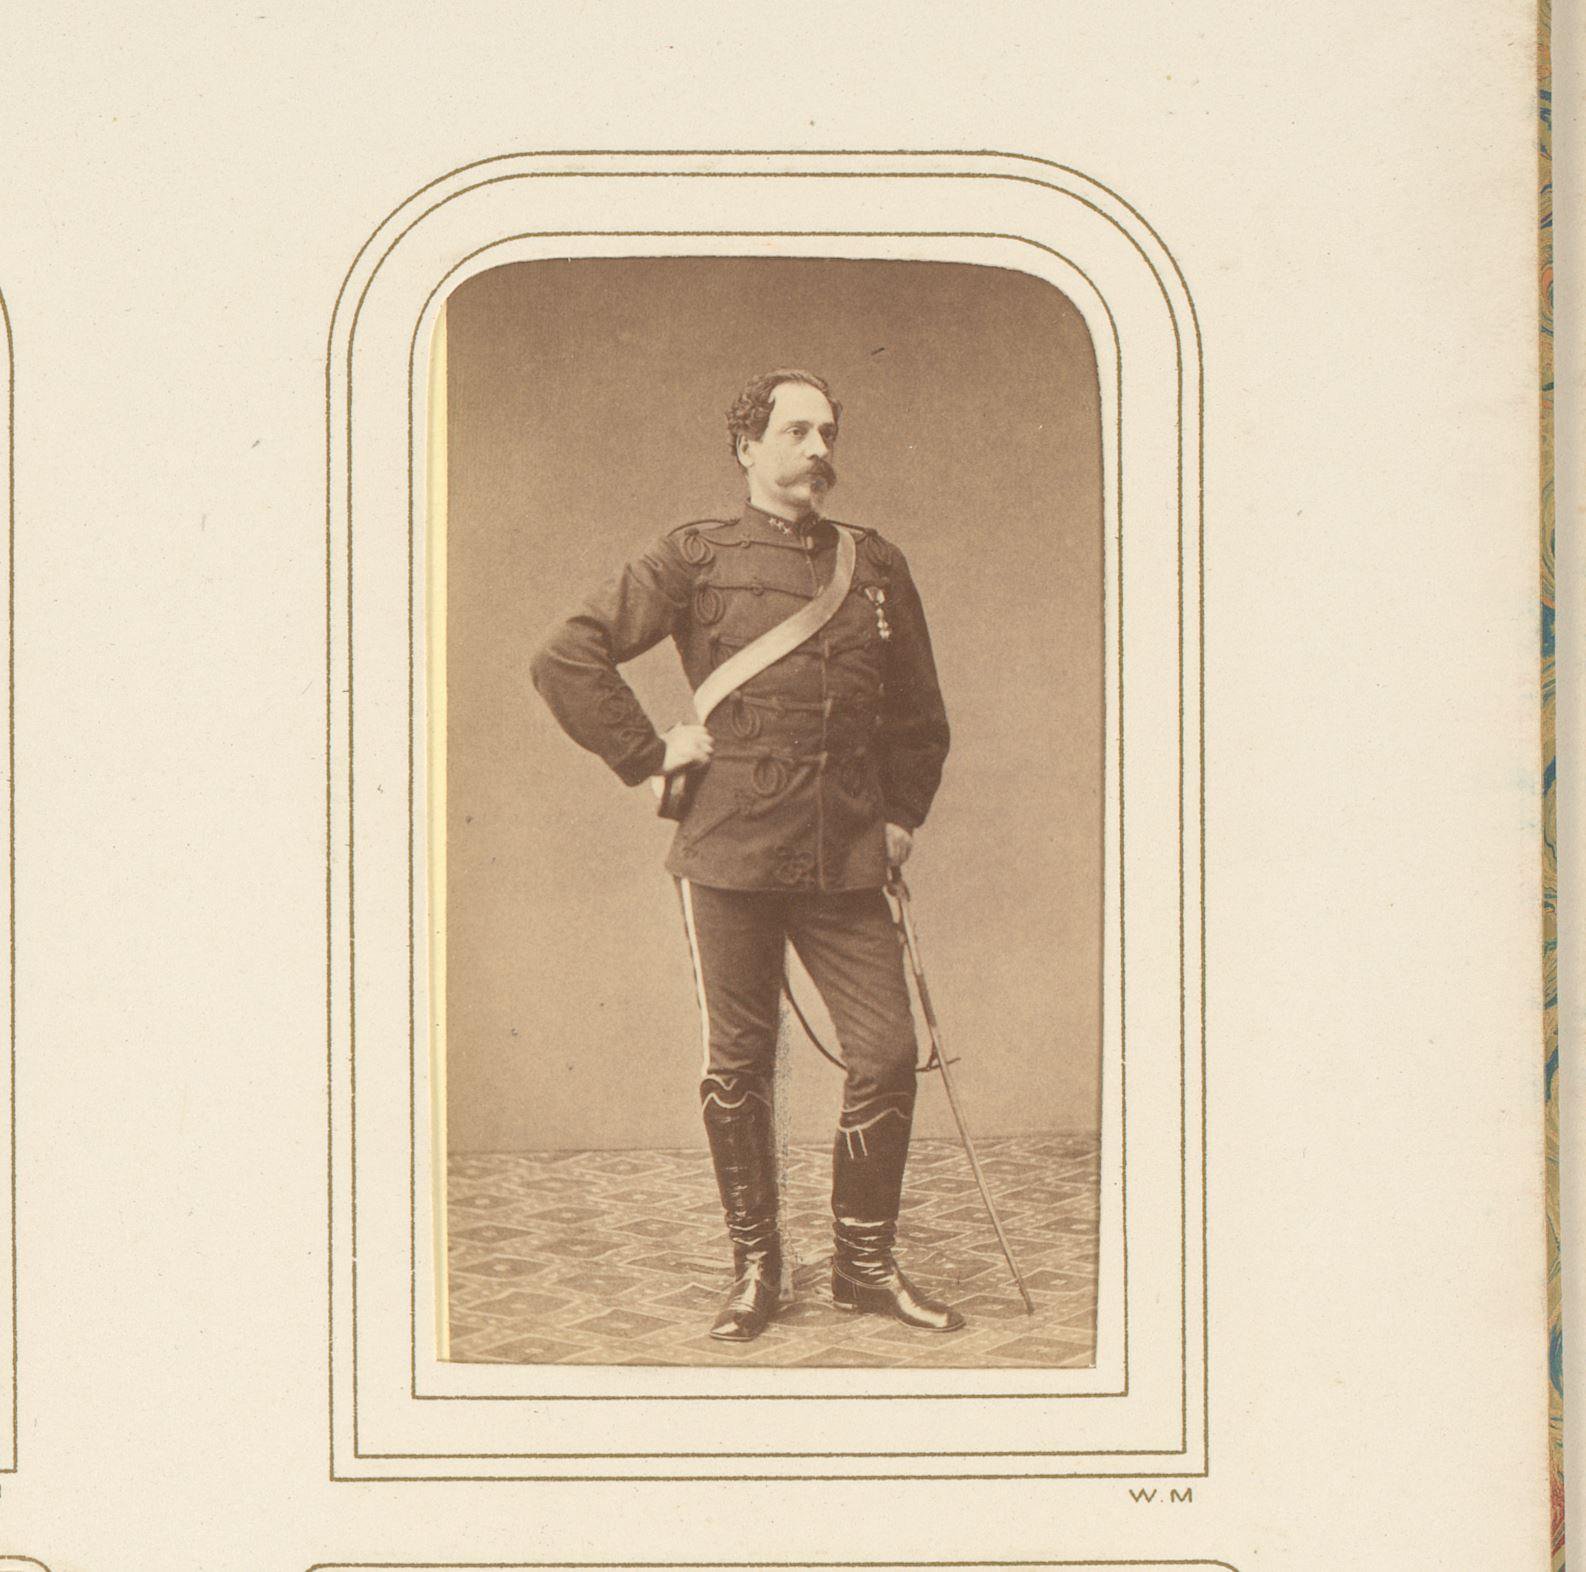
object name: carte de visite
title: Portret van Gustaf Frederikson in militair uniform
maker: augusta zetterling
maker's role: fotograaf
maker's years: 1840-1898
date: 1865-1885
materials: cardboard, photographic support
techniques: albumen print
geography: stockholm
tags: historical persons, portrait of actor, actress, (military) uniforms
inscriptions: annotation: ‘Kurt i Dagtingan’, inscription: ‘Augusta Zetterling/ jödd Böhme/ Stockholm/ Norra Smedjegatan No 5.’, annotation: ‘Gustaf Frederikson/ 1832 - 1921’